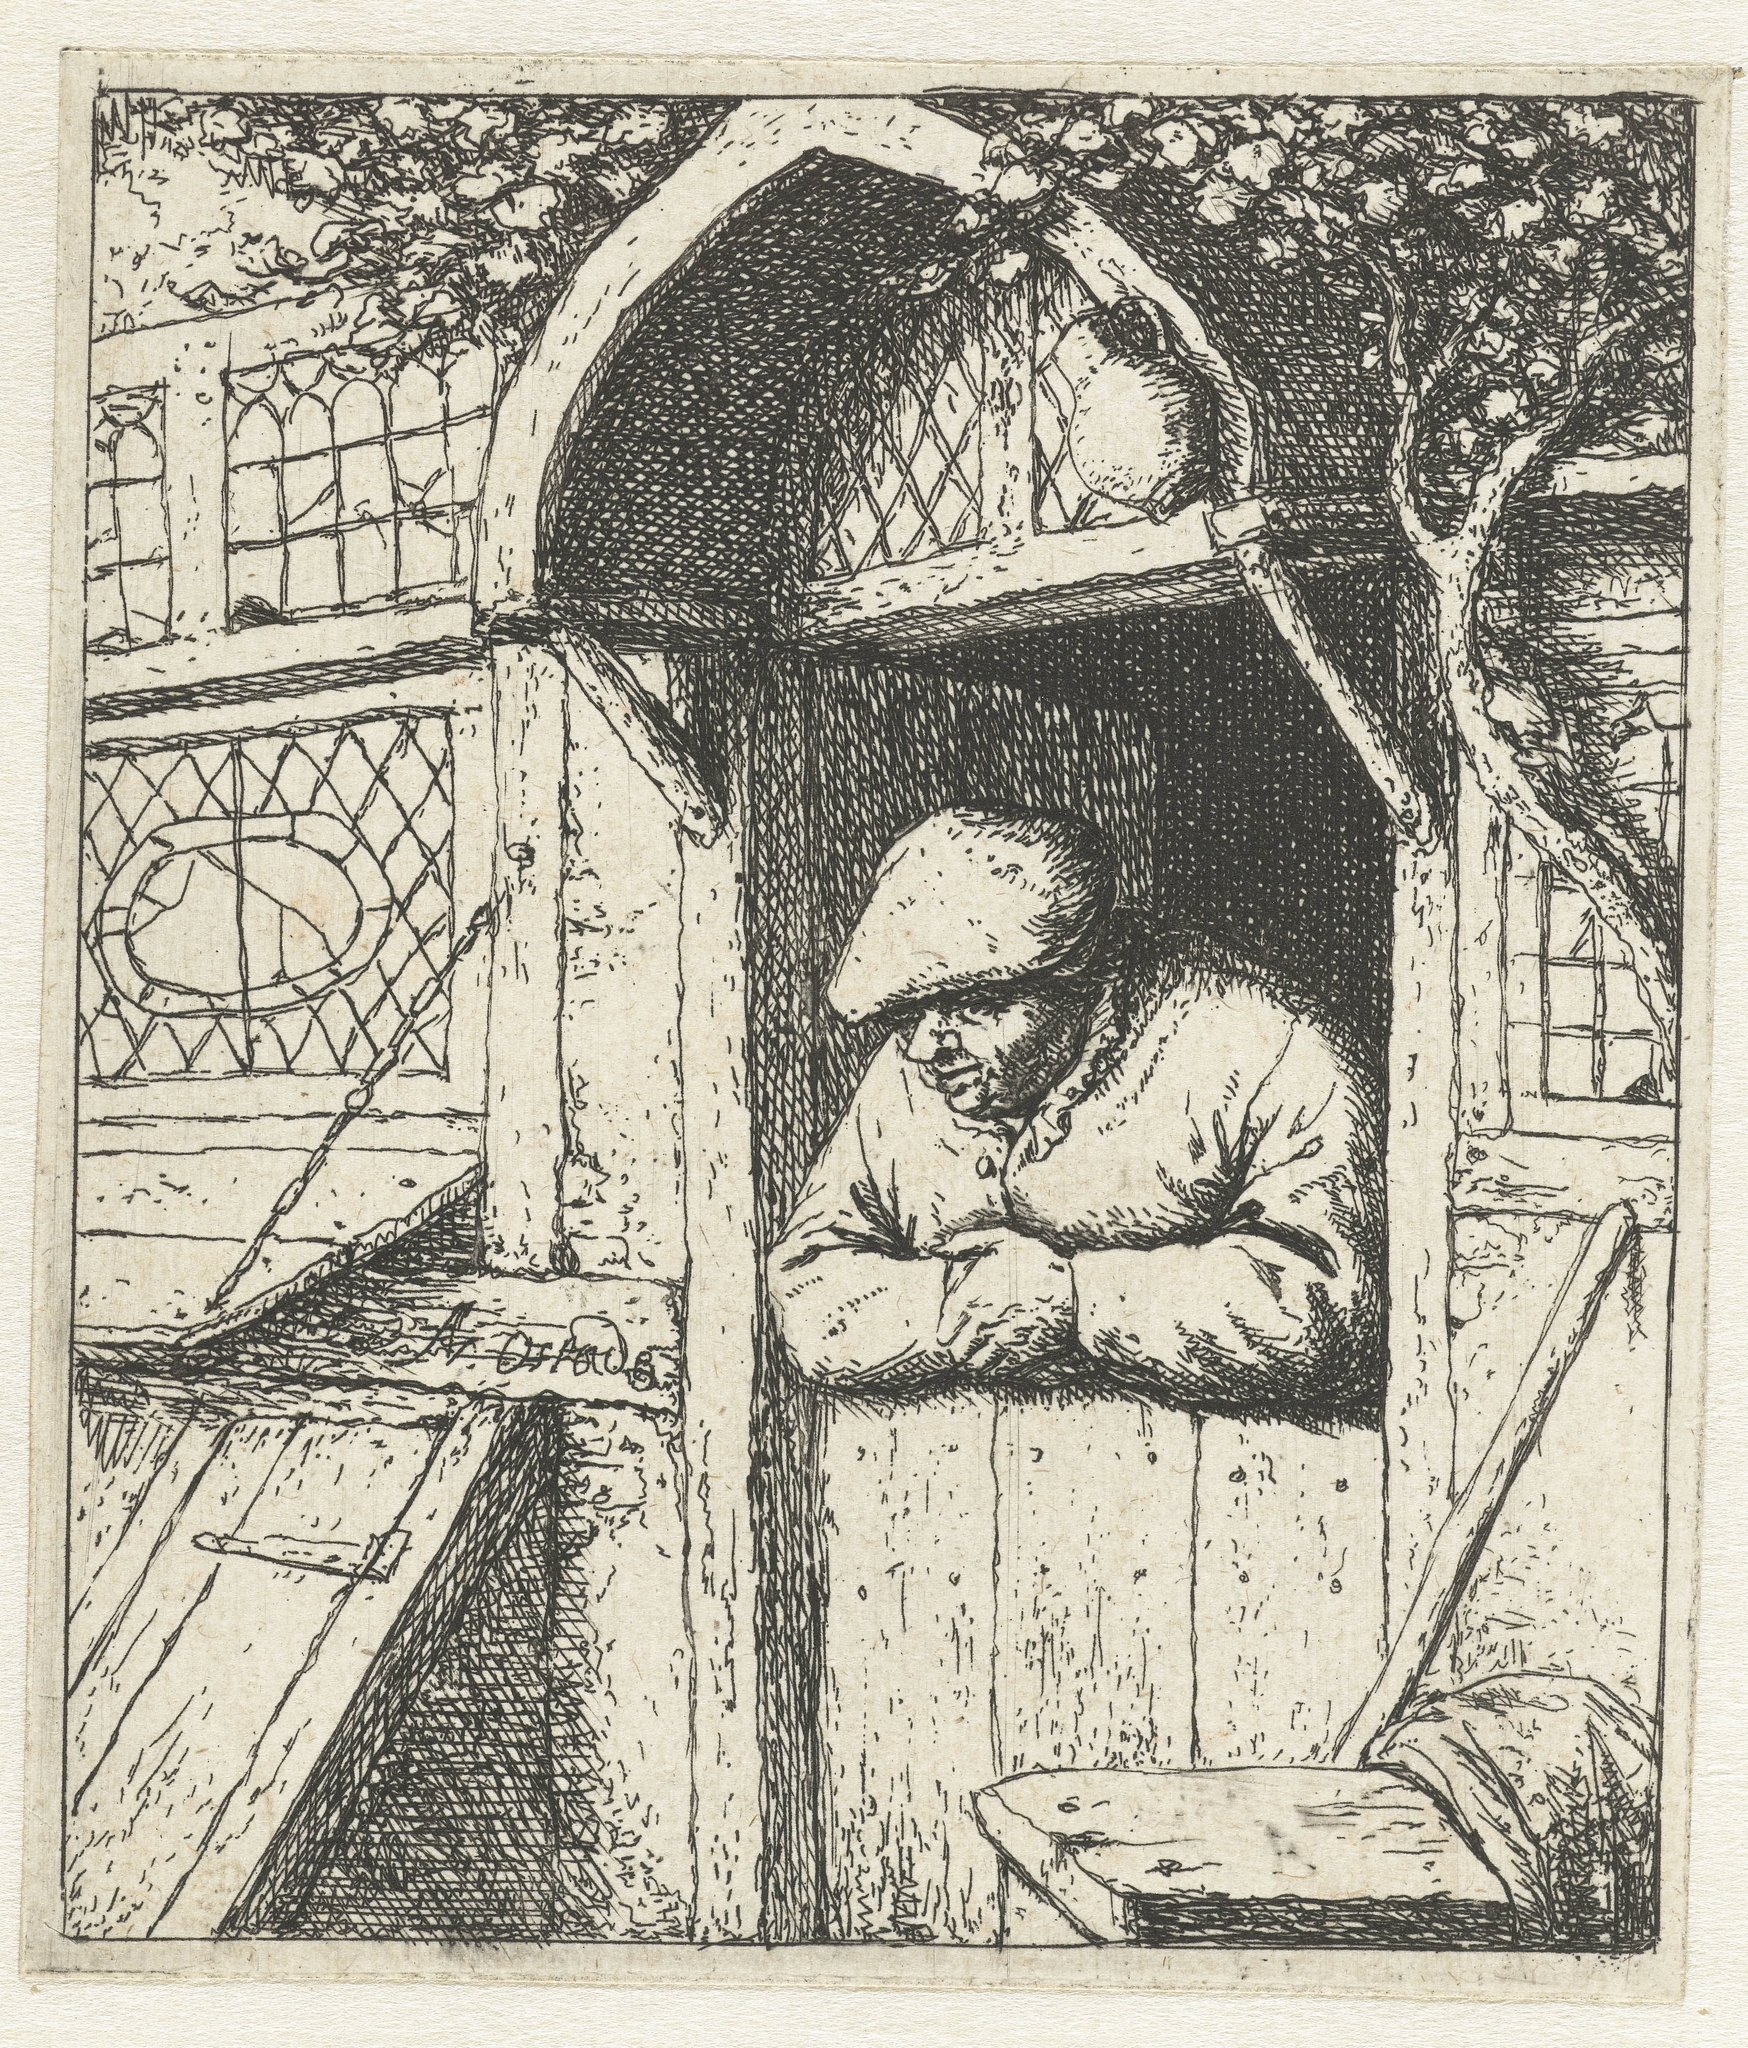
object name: print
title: Farmer Leaning on the Lower Half of a Door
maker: adriaen van ostade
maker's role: draughtsman, painter, print maker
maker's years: 1610-1685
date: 1651-1655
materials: paper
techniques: etching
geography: haarlem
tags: divided door, upper part opened, male sex; man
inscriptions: collector's mark: Lugt 240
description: Adriaen van Ostade often made preparatory drawings for his compositions. Here he worked out the man leaning over the lower half of a door. The blue paper allowed him to draw the shapes in black chalk as well as experiment with the distribution of light using white chalk. The heavily accentuated areas on the man’s jaw and around his hands suggest this was the first drawing for the composition.